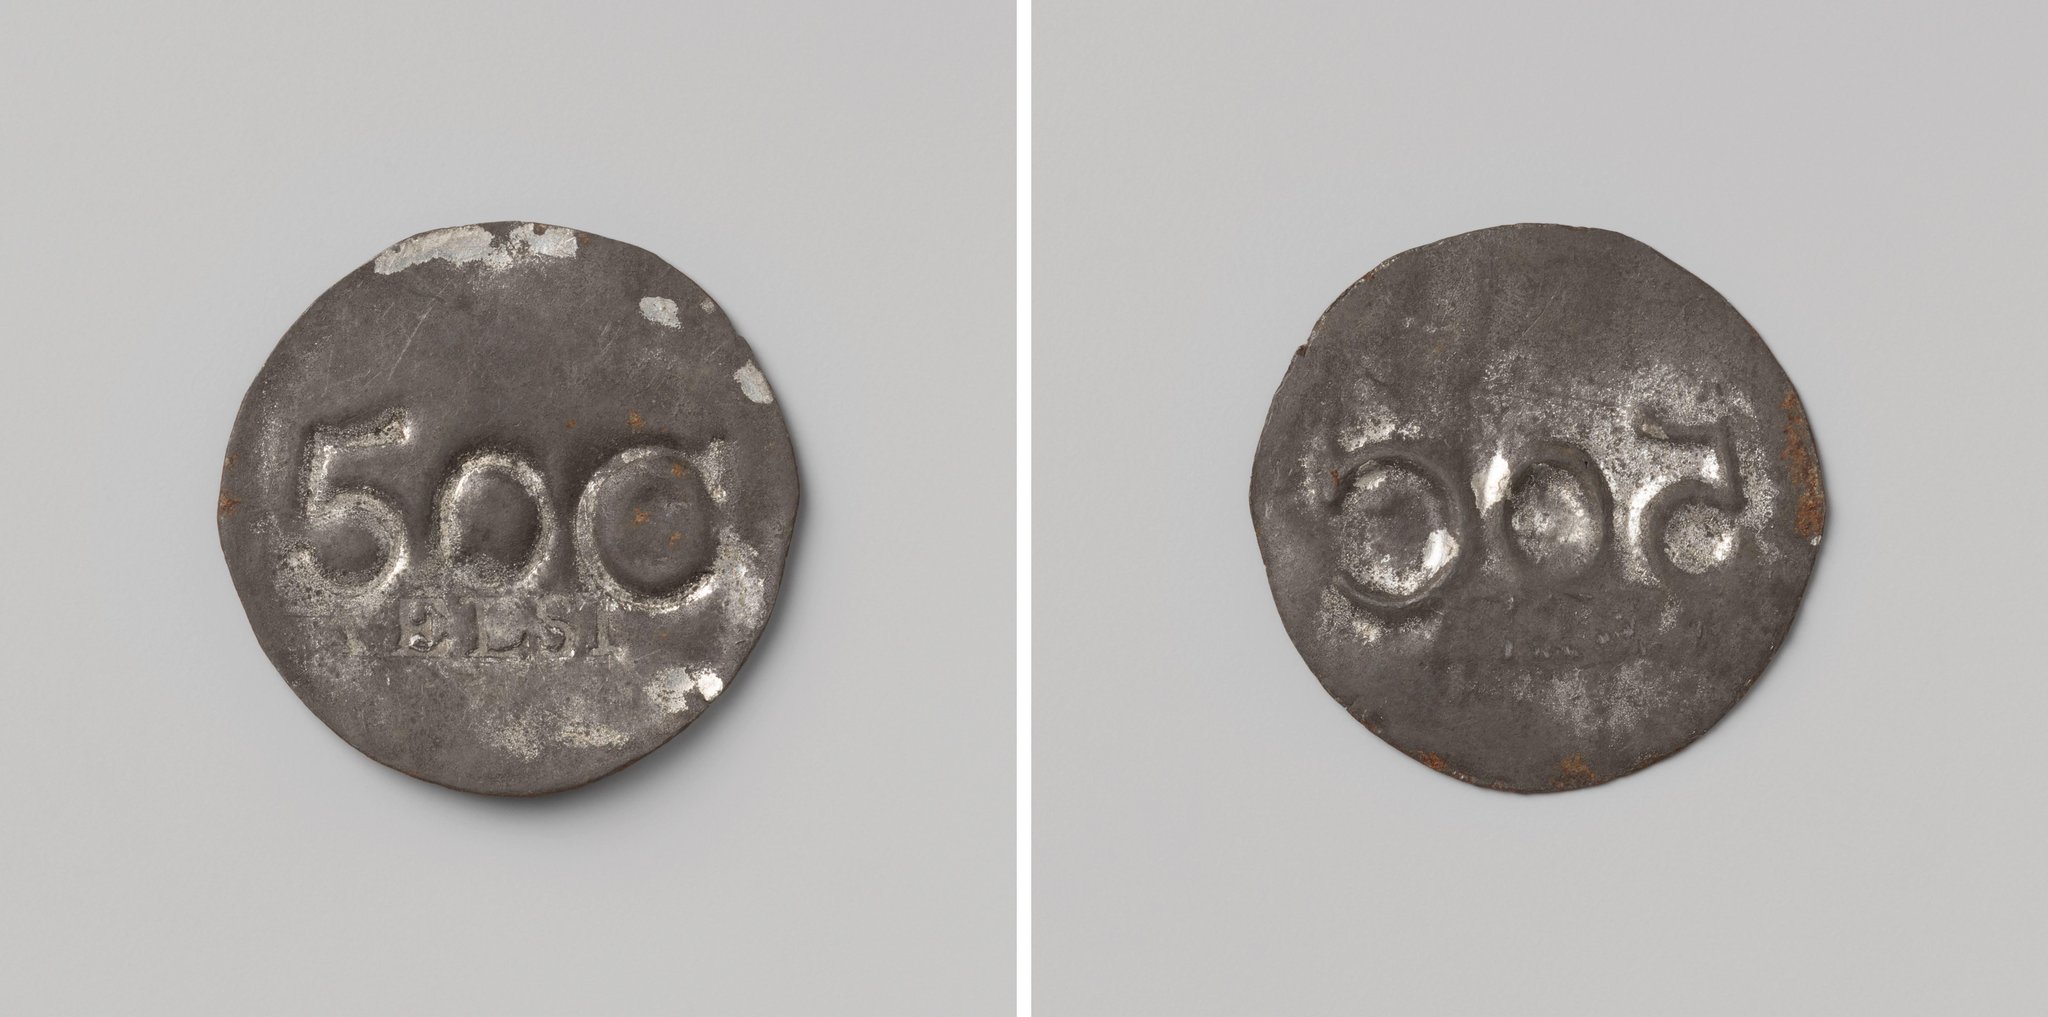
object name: monetary token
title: Gevangenisgeld van vijftig cent uit Aalst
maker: d.a. schretlen junior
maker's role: blikslager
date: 1827-1830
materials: silver, metal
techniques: silvering, striking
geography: leiden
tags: elst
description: eenzijdige betaalpenning. Voorzijde: waardeaanduiding boven klop: met opschrift 'K ELST'. Keerzijde: blanco